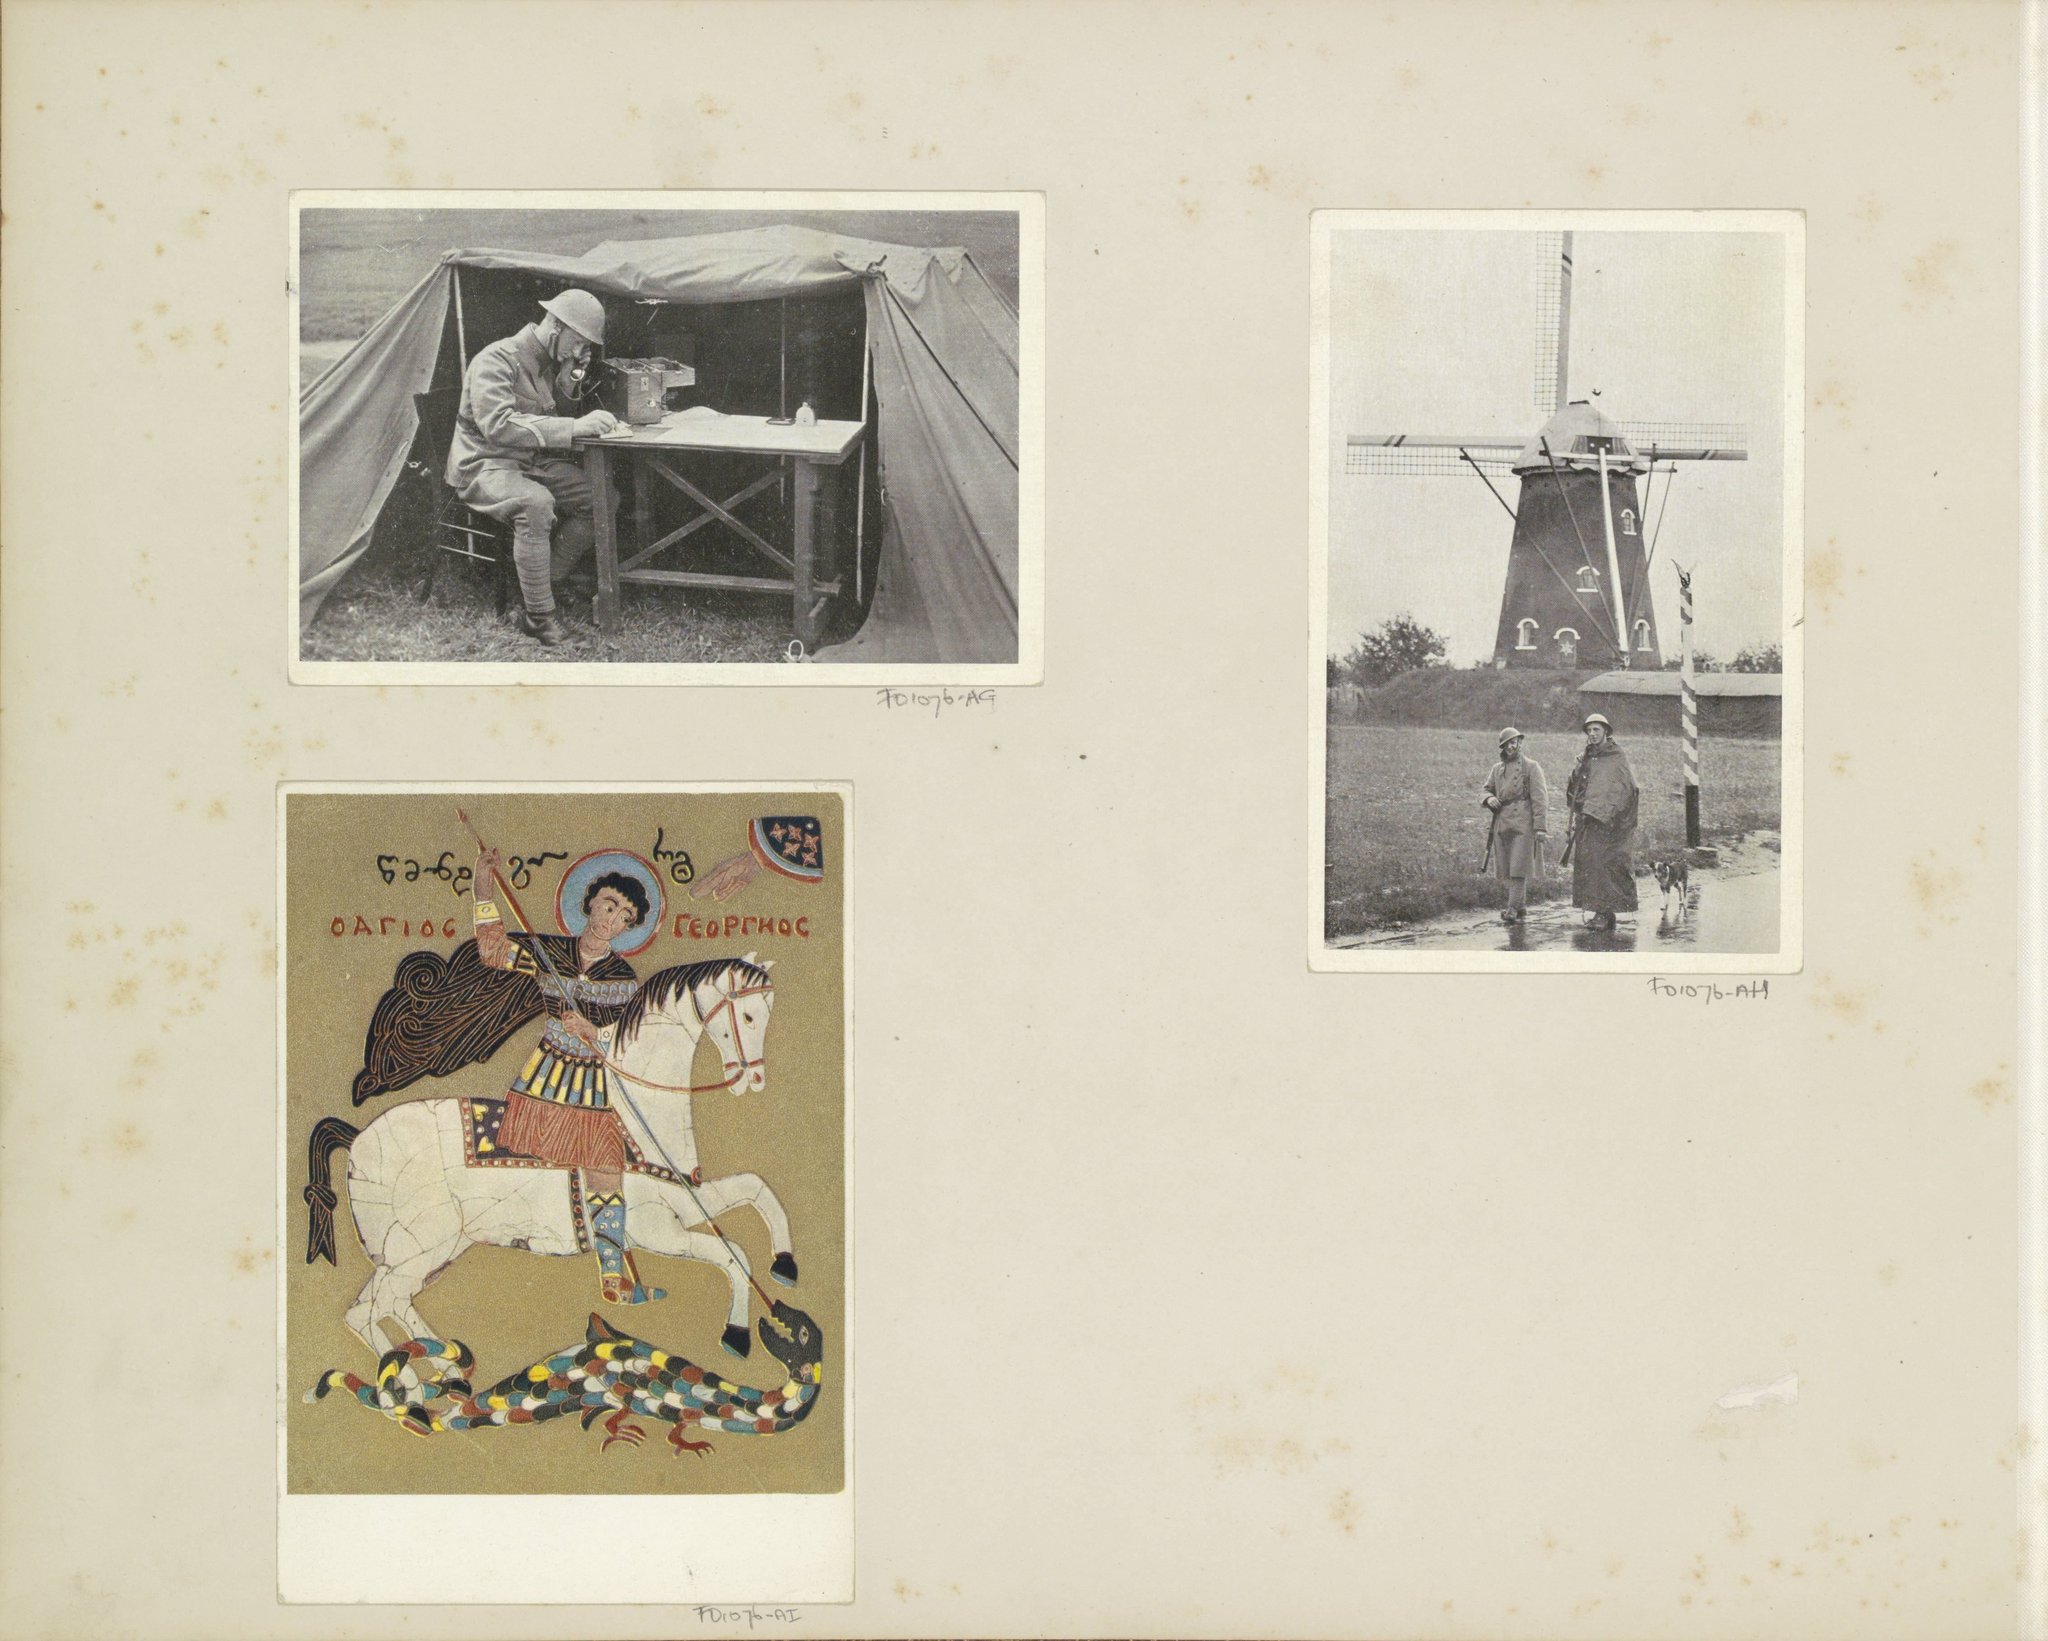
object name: photograph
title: Fotoreproductie van een afbeelding van Sint-Joris en de draak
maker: Anonymous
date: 1900-1940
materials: cardboard, paper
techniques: rotogravure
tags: dragon, the warrior martyr george (georgius); possible attributes: banner (red cross on white field), (red) cross, dragon, (white) horse, broken lance, shield (with cross), sword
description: Onderdeel van Album met foto's van spoorwegen in Nederlands-Indië en prentbriefkaarten.